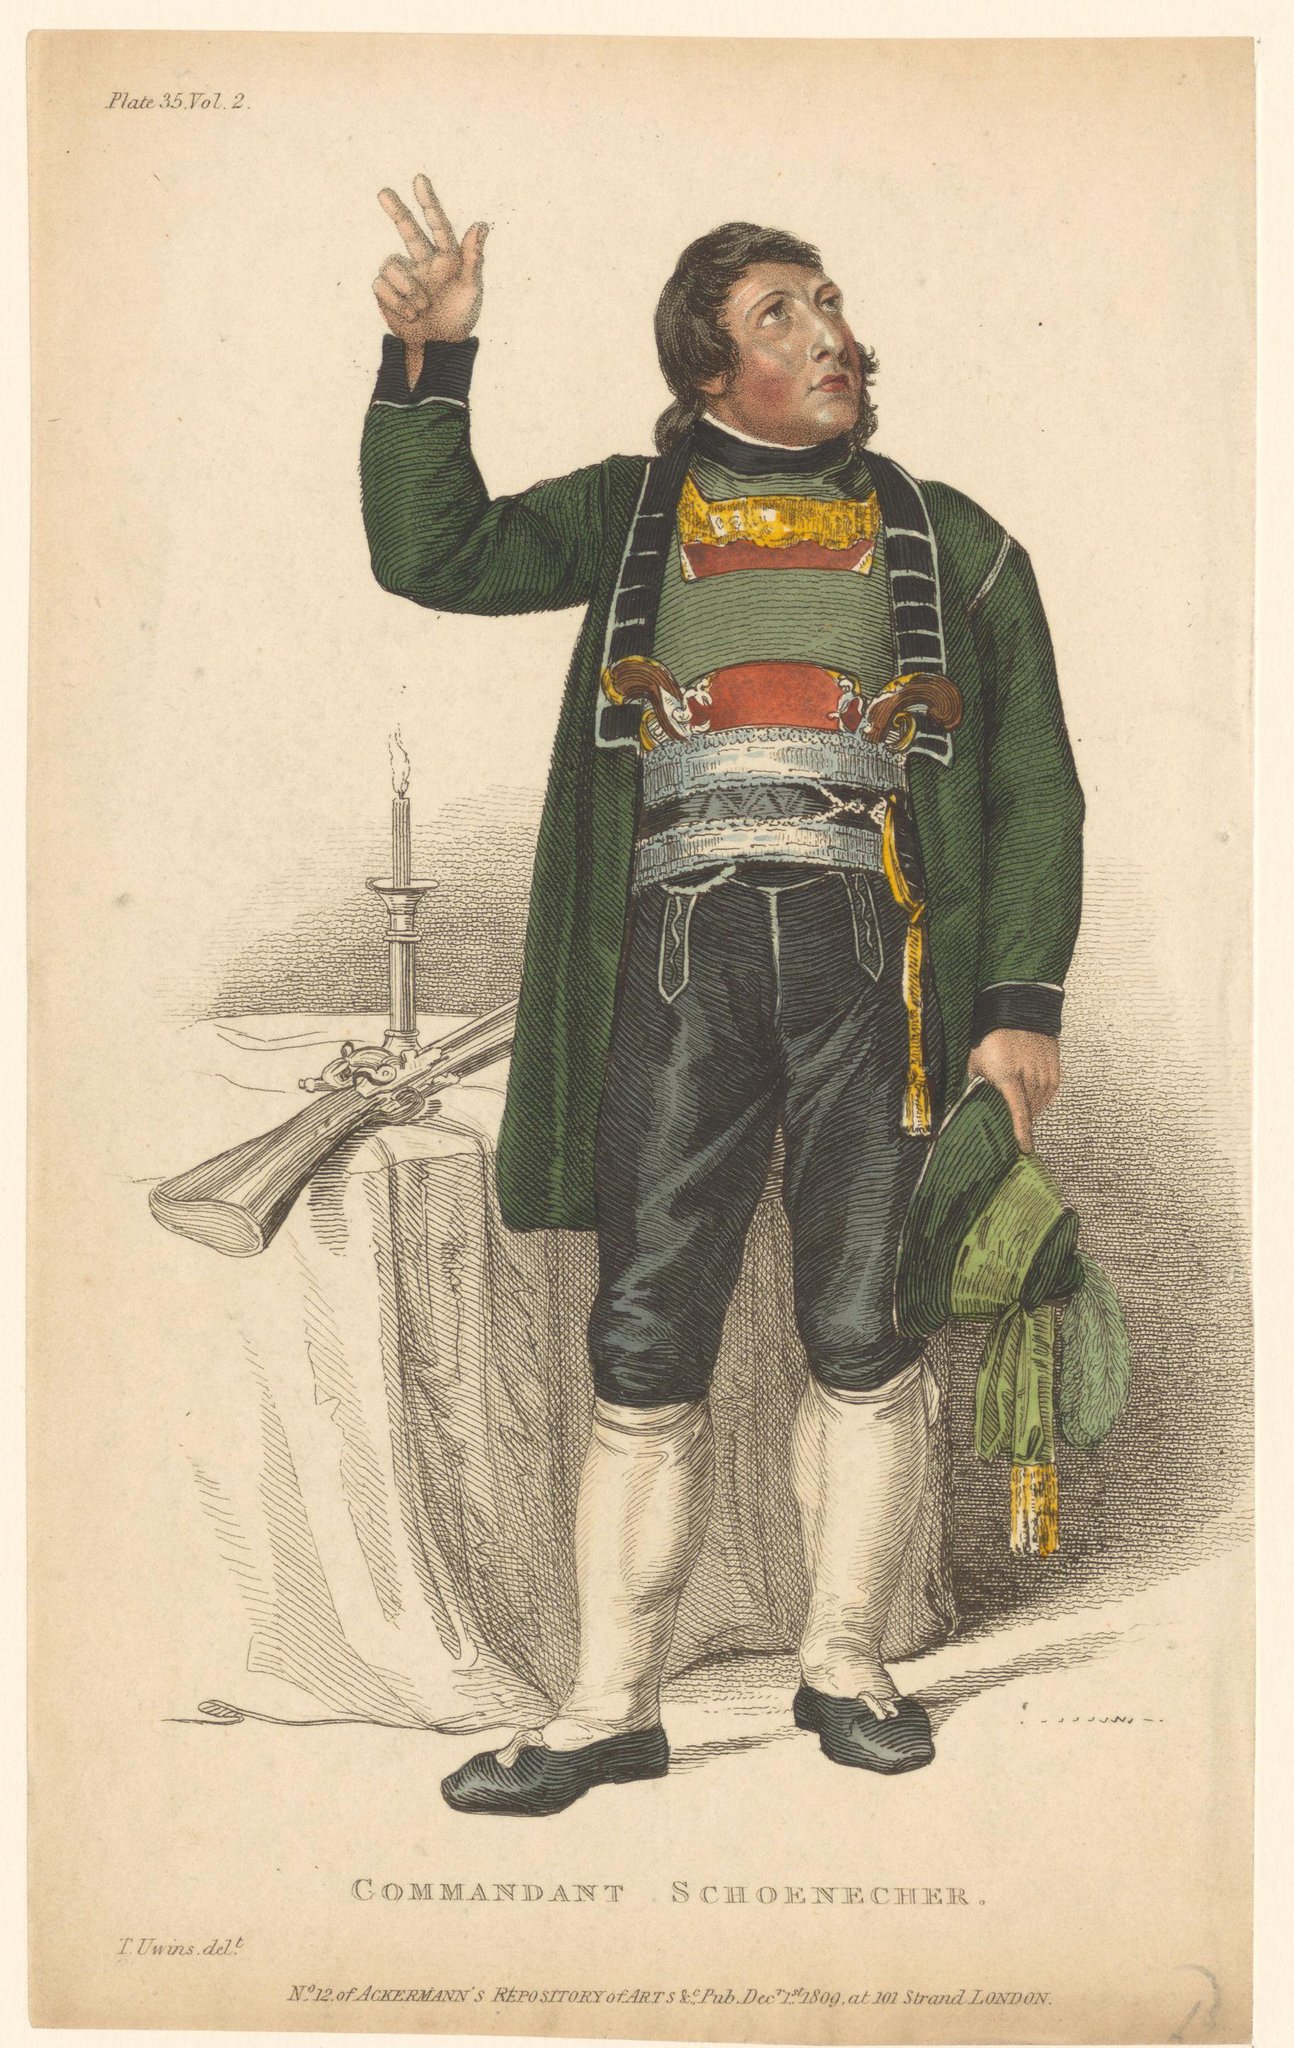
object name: book illustration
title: Portret van commandant Schoenecher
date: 1809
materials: paper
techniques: etching, hand coloring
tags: commander-in-chief, general, marshal, historical persons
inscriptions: collector's mark: Lugt 2228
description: Prent gebruikt in: Ackermann, Rudolph. The Repository of Arts, Literature, Commerce, Manufactures, Fashions and Politics. Londen: Lancelot Harrison, 1809.